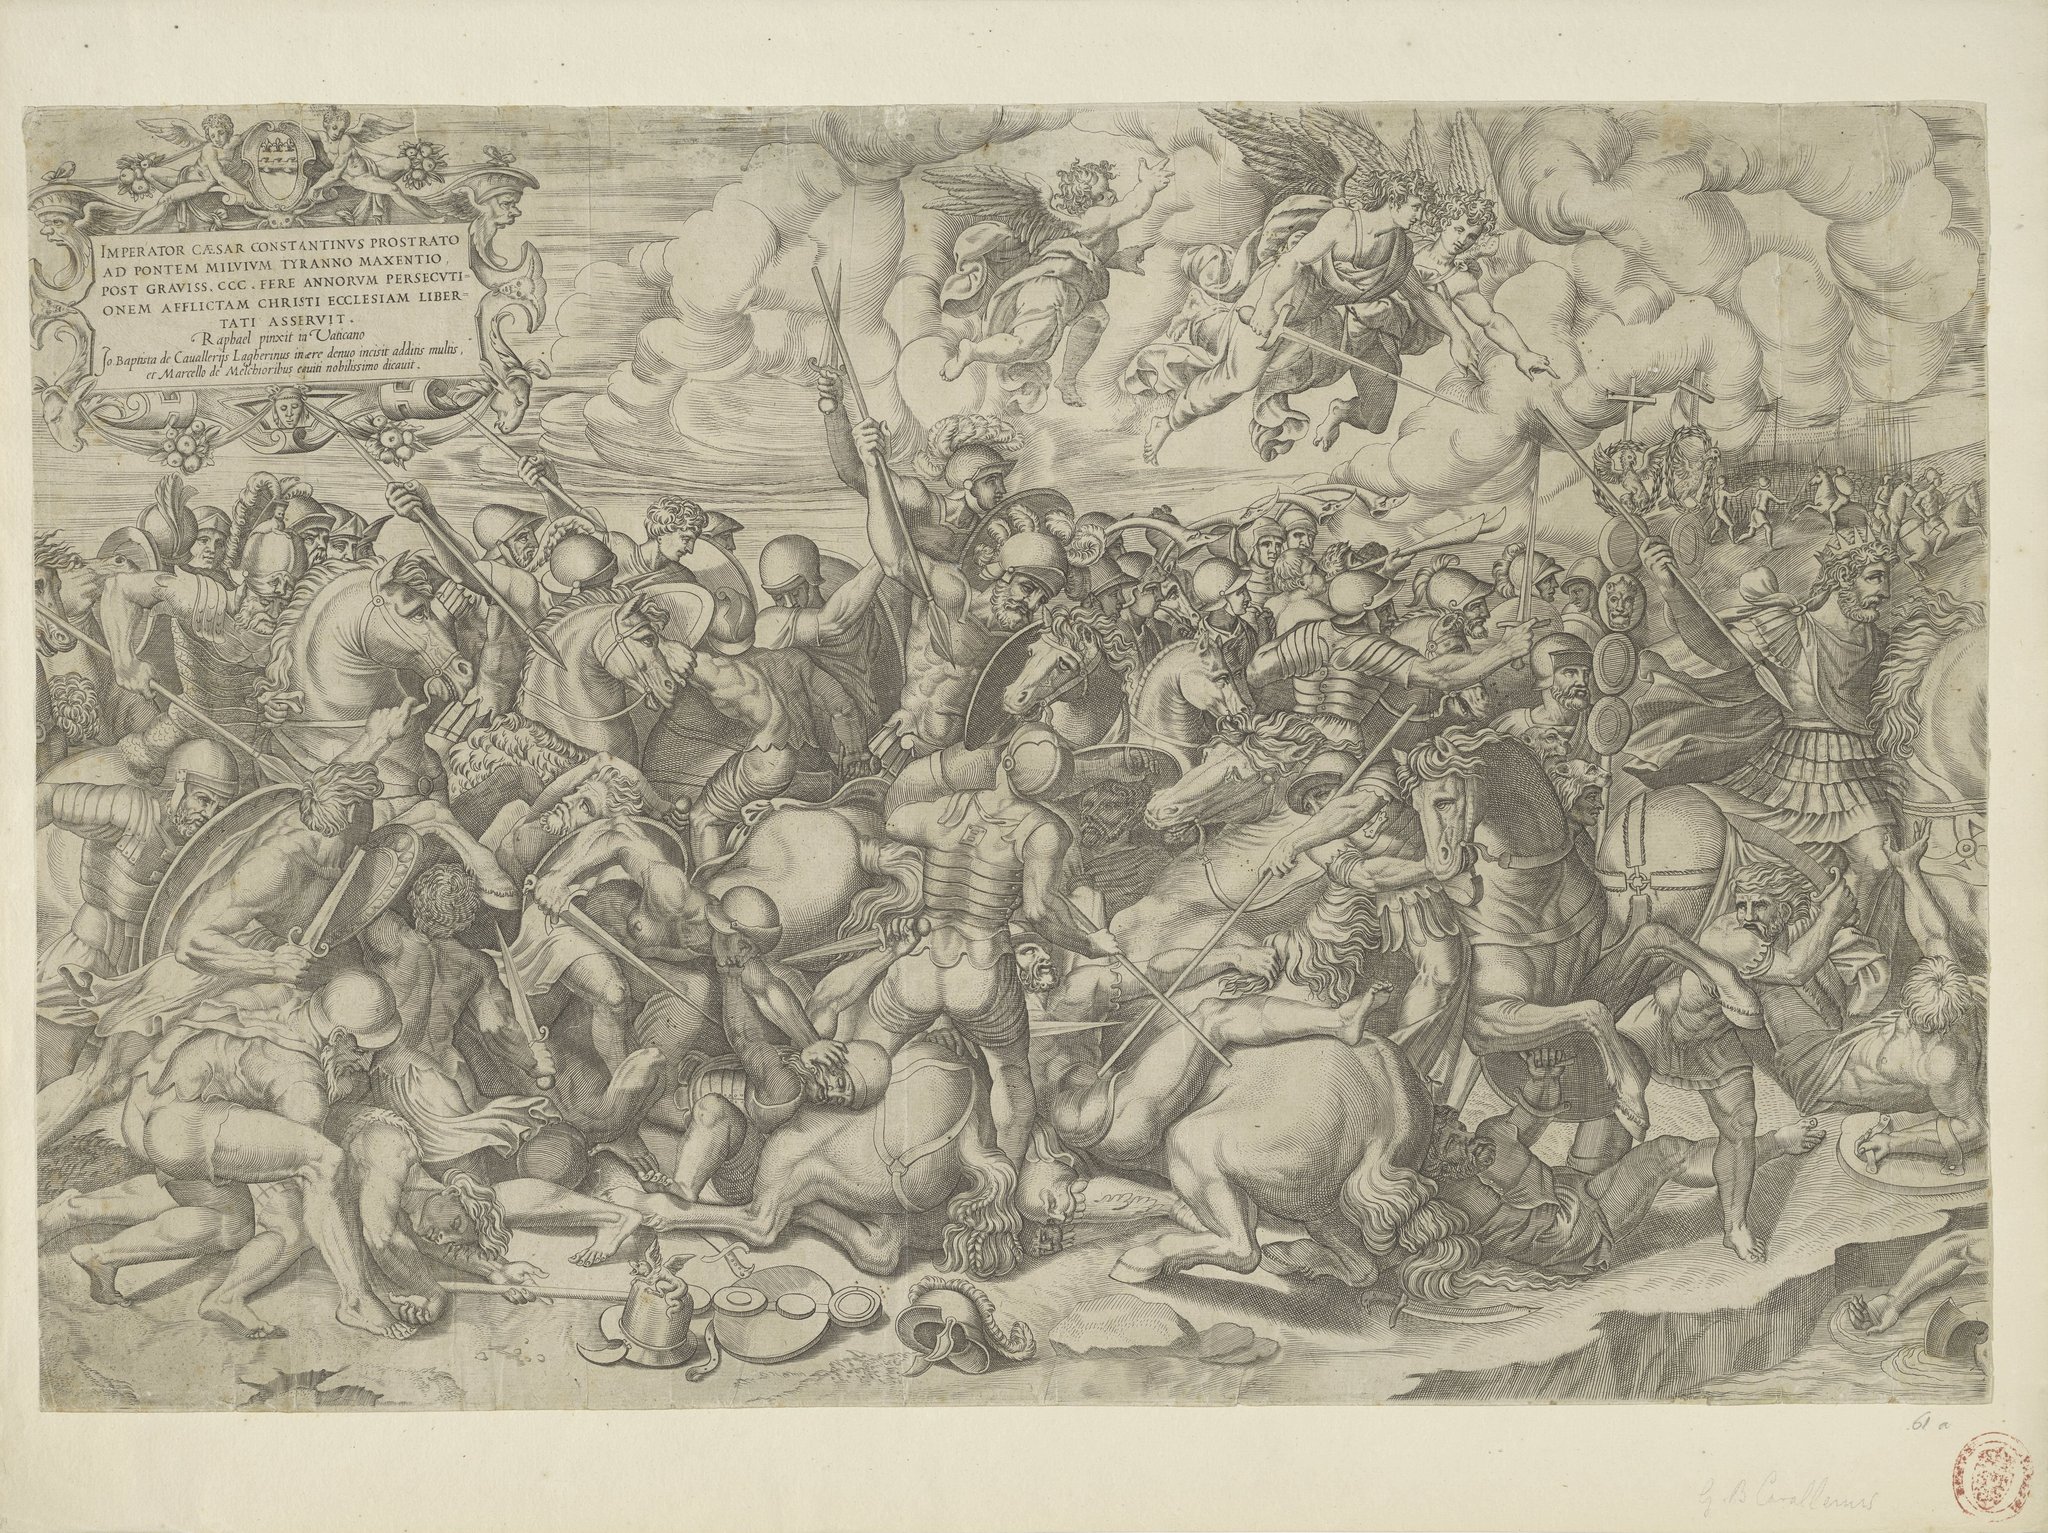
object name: print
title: Slag bij de Milvische brug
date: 1535-1601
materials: paper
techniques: engraving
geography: italy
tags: the battle of the milvian bridge (saxa rubra): st. constantine on horseback confronts maxentius; a cross appears in the sky with in fiery letters 'in hoc signo vinces' (the raised standards of the roman soldiers carry a cross or the chi-rho monogram), warfare; military affairs (+ cavalry, horsemen), the soldier; the soldier's life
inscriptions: collector's mark: Lugt 240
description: Gevechtsscène in een landschap: slag bij de Milvische brug. De soldaten van Constantijn in gevecht met de soldaten van Maxentius. Dode lichamen liggen op de grond. Soldaten te paard verdrinken in de rivier.